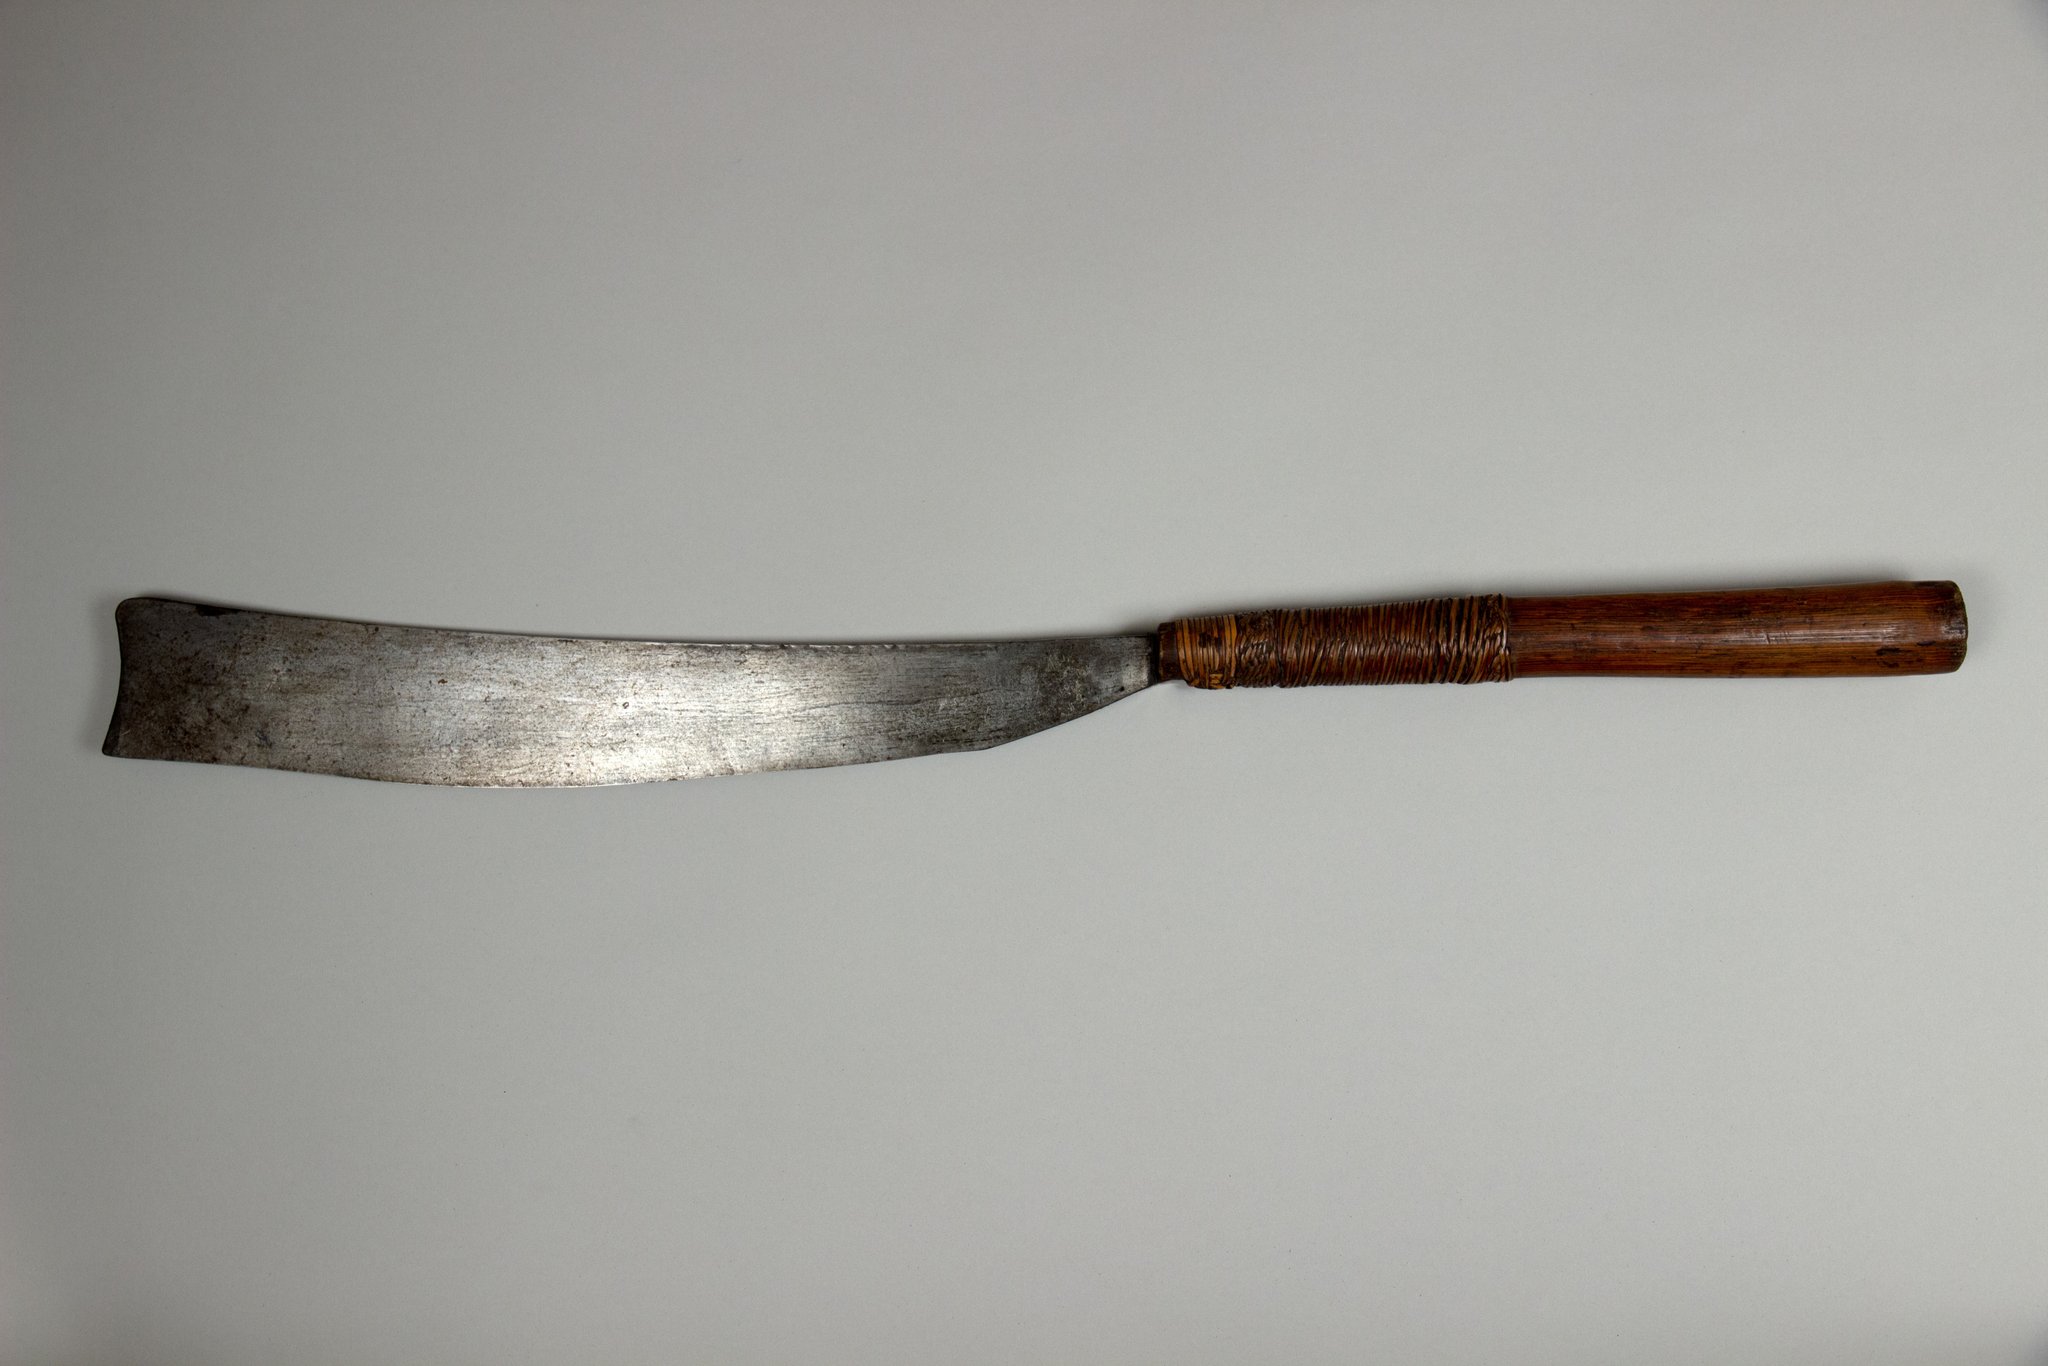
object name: chopper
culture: indian, assam or naga hills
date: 1801-1900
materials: metal, wood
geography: india